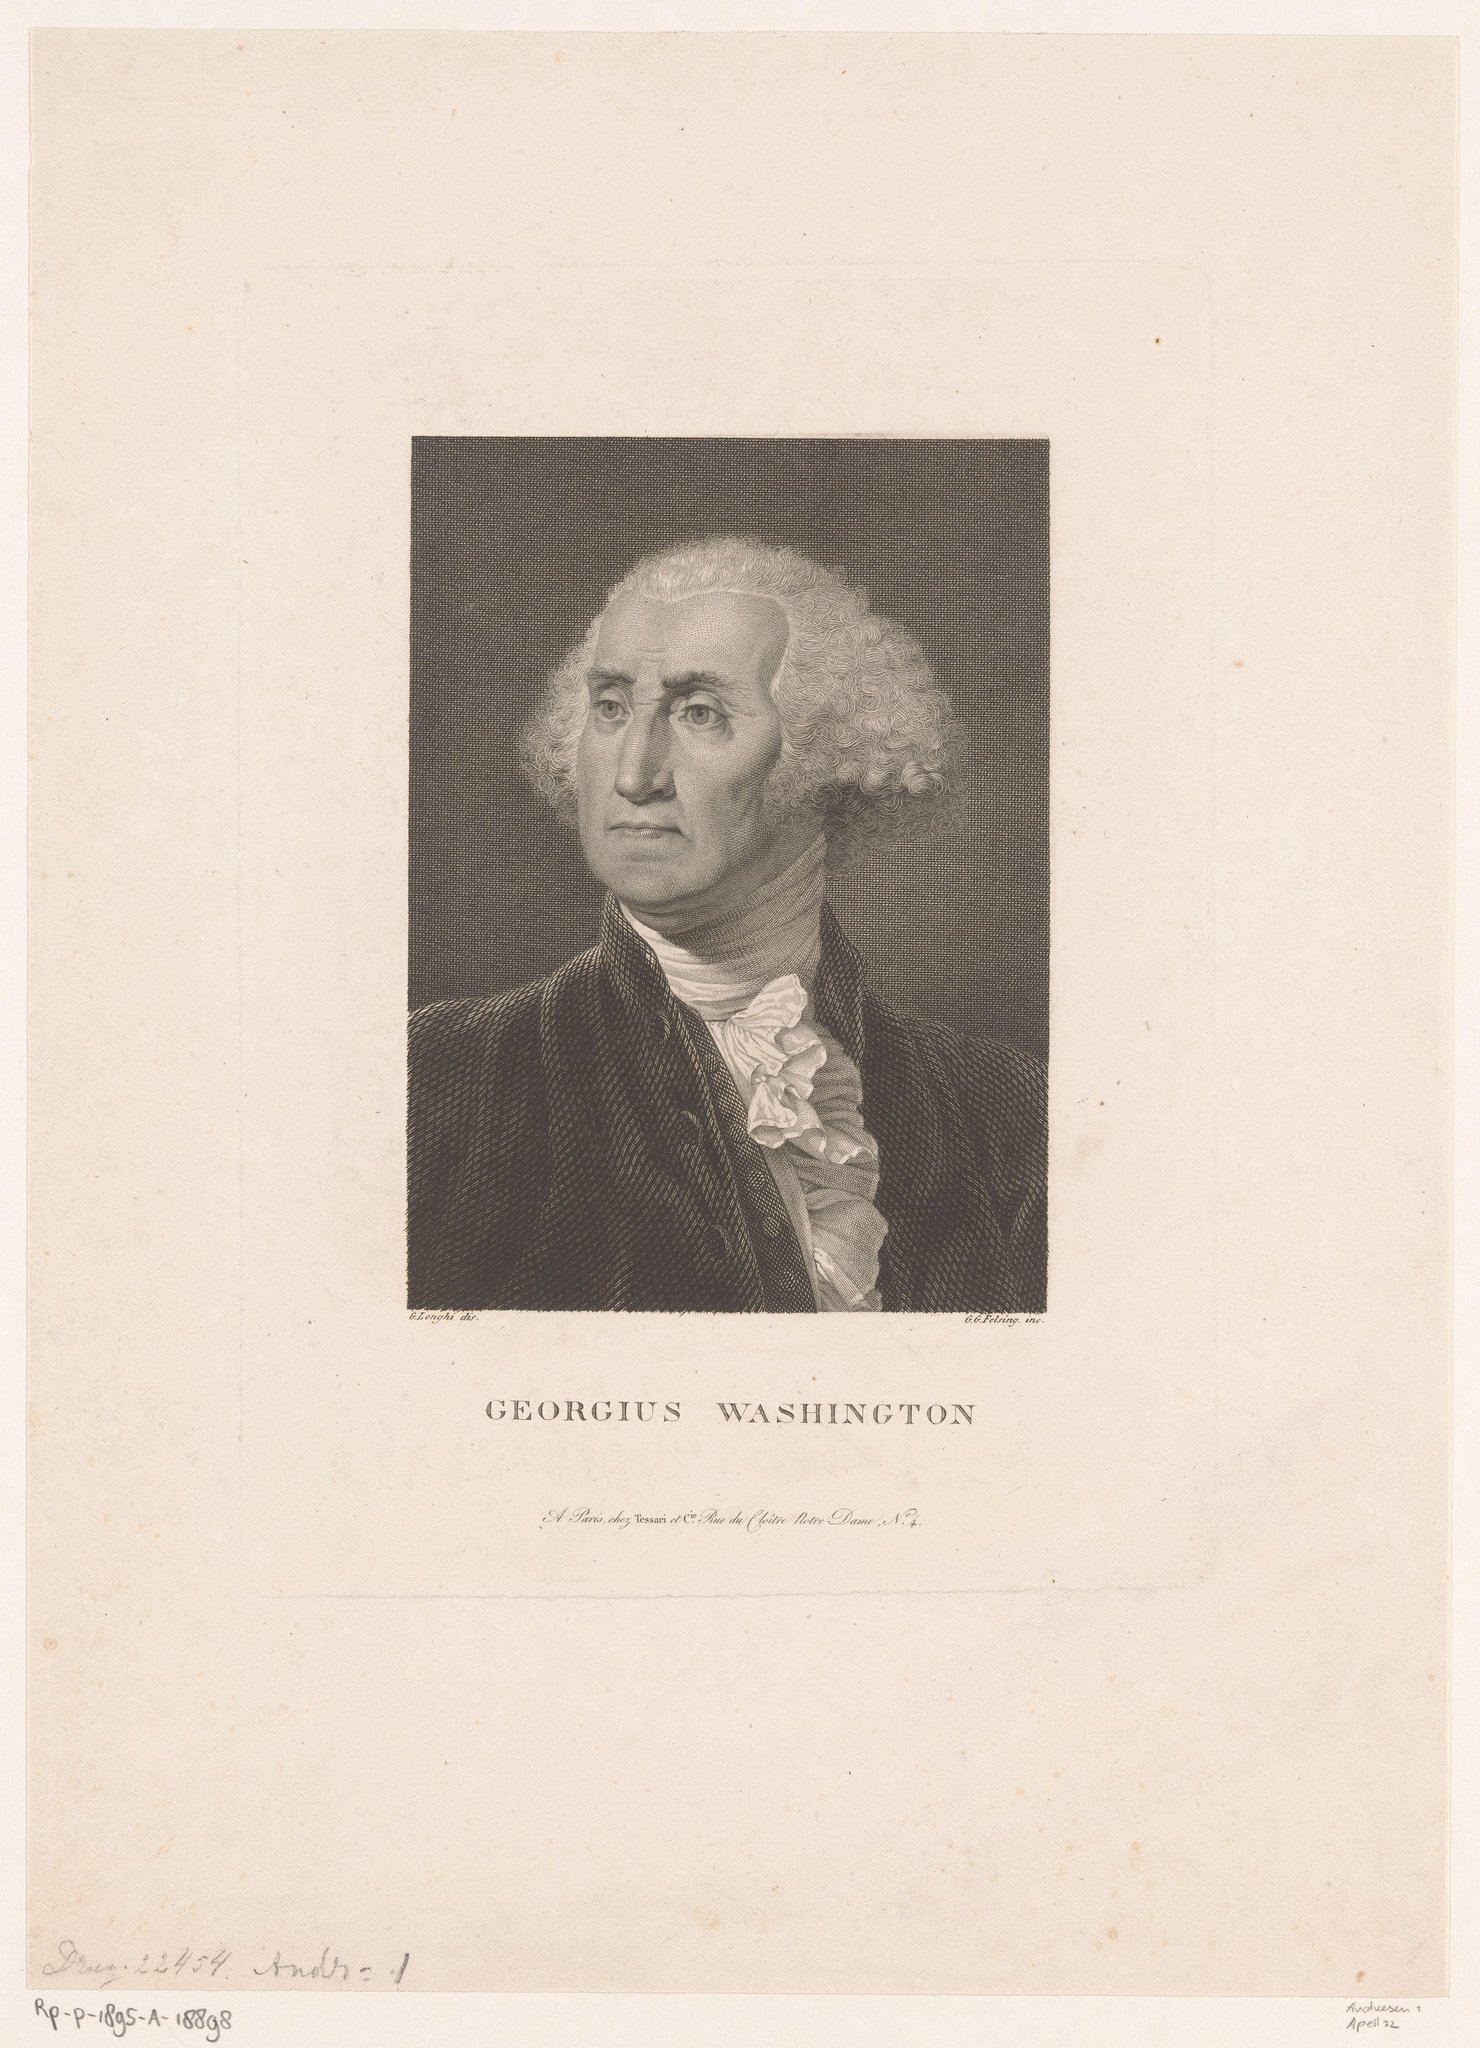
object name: print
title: Portret van George Washington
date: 1824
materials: paper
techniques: engraving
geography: paris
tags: historical persons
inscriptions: collector's mark: Lugt 2228